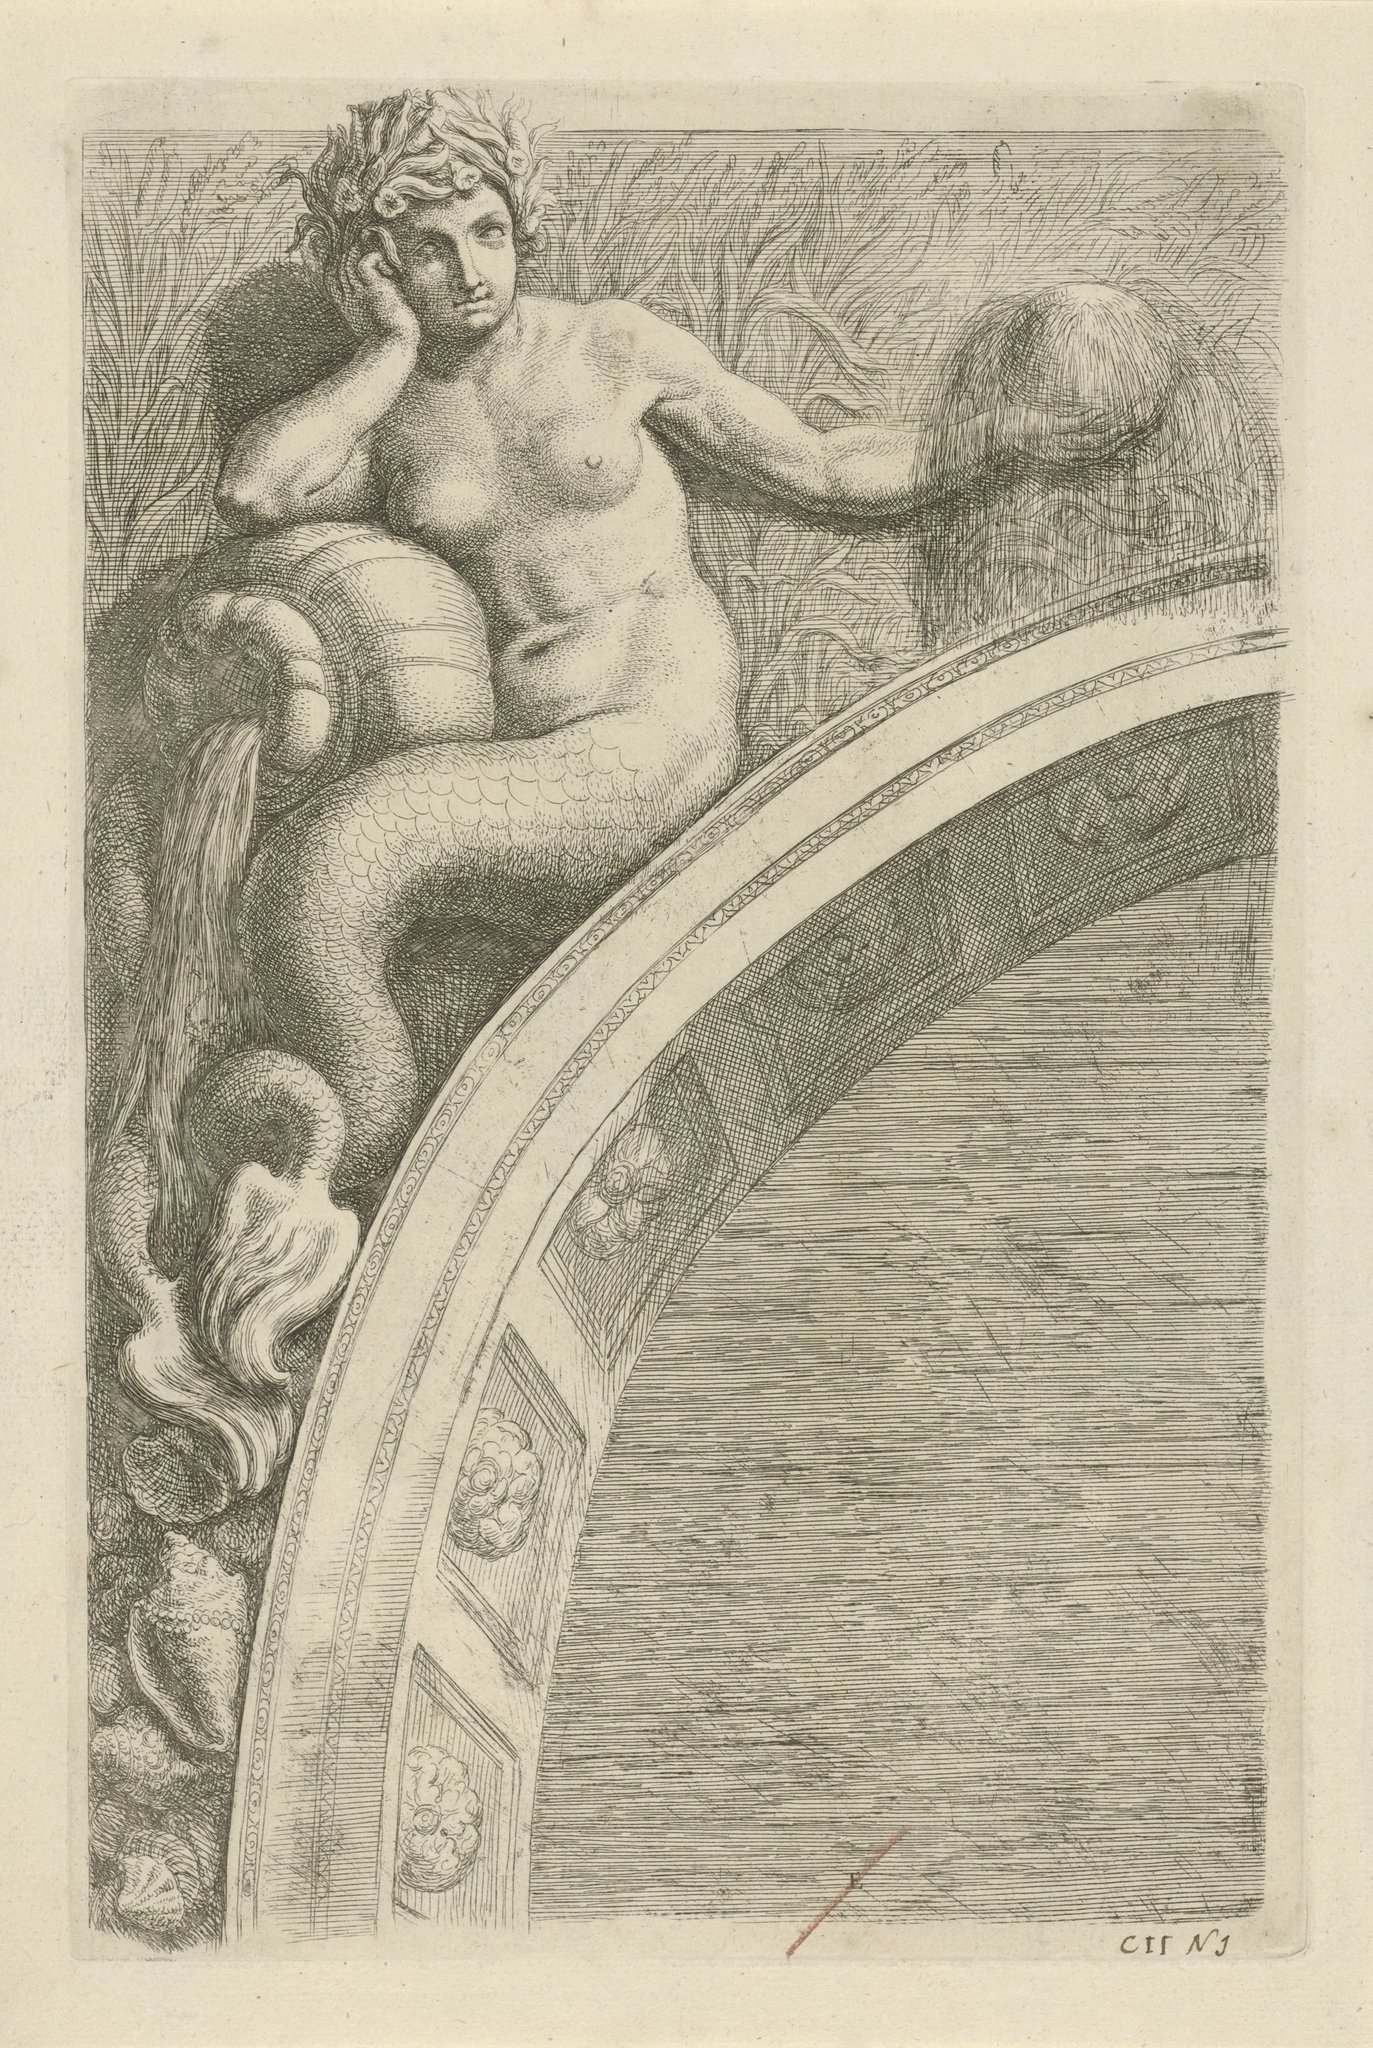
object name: book illustration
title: Reliëf met personificatie van het element Water boven boog aan westzijde van de Burgerzaal in het Stadhuis op de Dam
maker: hubert quellinus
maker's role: print maker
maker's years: 1619-1687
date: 1663-1668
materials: chalk, ink, paper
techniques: engraving, etching, pen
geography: amsterdam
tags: merman - aa - mermaid, siren (+ tail), water (one of the four elements), scallop, shell ~ ornament, container of ceramics: jar, jug, pot, vase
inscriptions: collector's mark: Lugt 2228, inscription: ‘CII N 1’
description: Huidige staat van prent ook gebruikt in: Secunca pars Praecipuarum effigierum ac ornamentorum amplissime Curiae Amstelrodamensis maiori ex parte in cadido marmore effectorum per Artum Quellinium eiusdem Civitatis Statuarium / Het tweede deel Van de voornaemste Statuen ende Cieraten van 't konst-rijcke Stadt-huys van Amstelredam 'tmeeste in Marmer gemaeckt door Artus Quellinus Beelthouwer der voorseyde Stadt. Amsterdam: Artus Quellinus (I), 1663. En in: Secunca pars Praecipuarum effigierum ac ornamentorum amplissime Curiae Amstelrodamensis maiori ex parte in cadido marmore effectorum per Artum Quellinium eiusdem Civitatis Statuarium / Het tweede deel Van de voornaemste Statuen ende Cieraten van 't konst-rijcke Stadt-huys van Amstelredam 'tmeeste in Marmer gemaeckt door Artus Quellinus Beelthouwer der voorseyde Stadt. Amsterdam: Frederik de Wit, 1668. Latere staat van prent ook gebruikt in: Architecture peinture et sculpture de la Maison de Ville d'Amsterdam, representee en CIX. figures en taille-douce (…). Amsterdam: David Mortier, 1719. En in: Architecture peinture et sculpture de la Maison de Ville d'Amsterdam, representee en CIX. figures en taille-douce (…). Amsterdam: Gerard Valck, 1719. En in: Bouw schilder en beeldhouwkonst, van het Stadhuis te Amsteldam, vertoont in CIX figuuren (…). Amsterdam: Covens & Mortier & Covens Jr., s.a. (1774-1783).